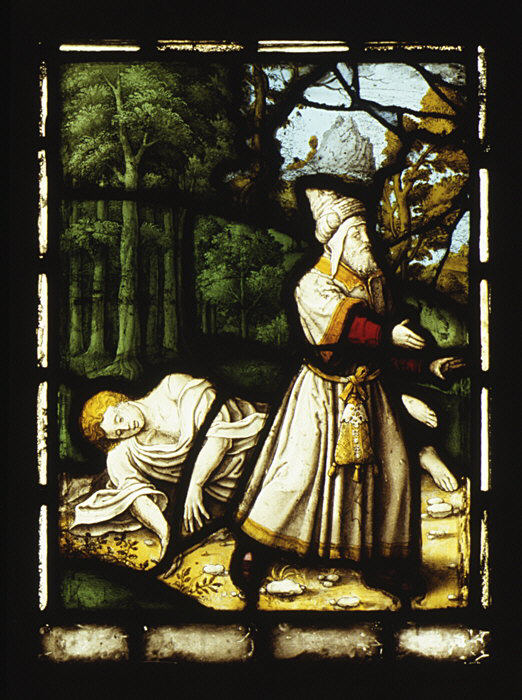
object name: panel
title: The Levite in the Parable of the Good Samaritan (one of a set of 12 scenes from The Life of Christ)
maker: jan rombouts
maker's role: maker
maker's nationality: south netherlandish (duchy of brabant)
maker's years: 1475-1535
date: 1525-1530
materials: glass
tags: men,trees,death